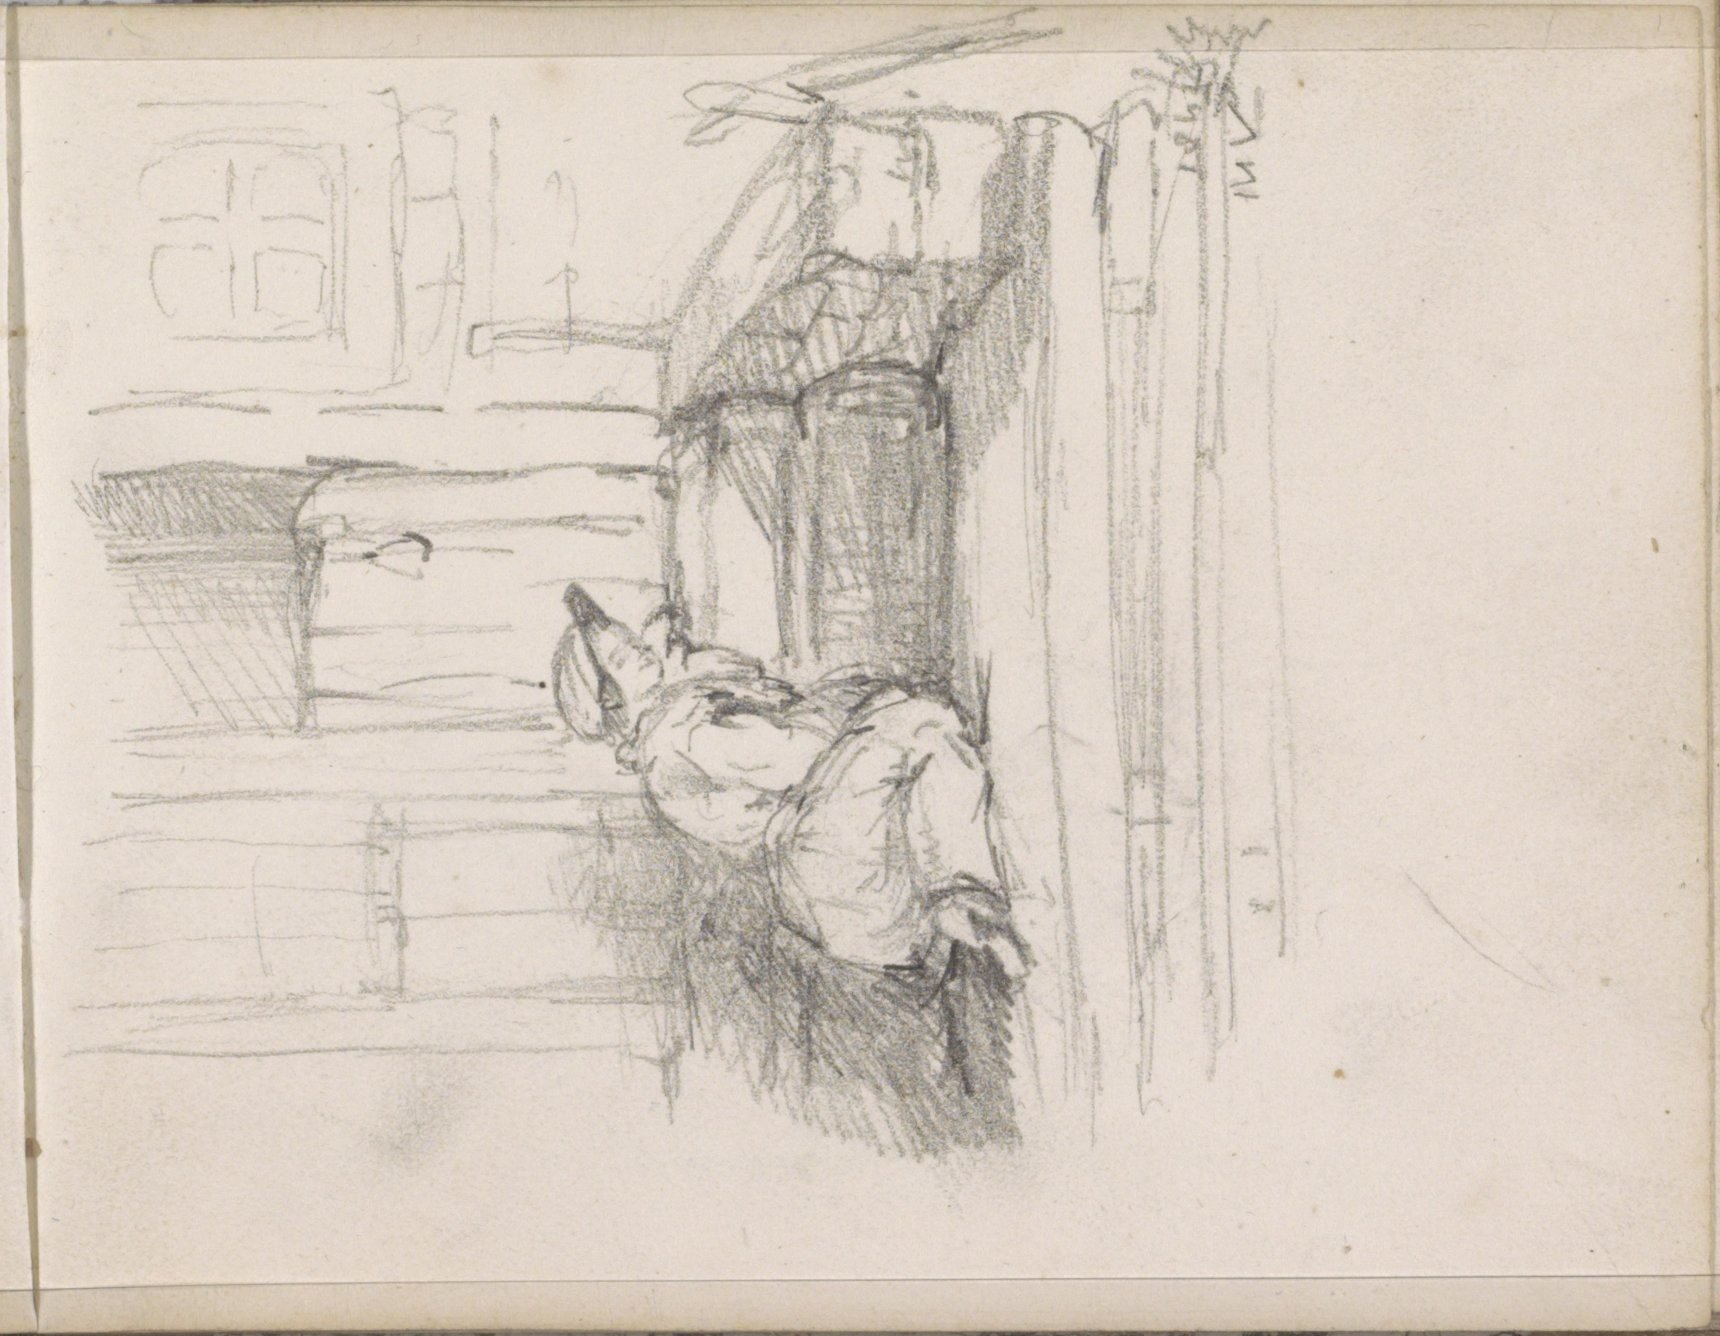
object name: sketchbook leaf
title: Interieur met een kind op een sofa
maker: maria vos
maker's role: draughtsman, painter, print maker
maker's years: 1824-1906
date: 1842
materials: paper, pencil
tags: child, interior of the house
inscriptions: monogram and date: ‘1842/ MV’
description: Blad 5 recto uit een schetsboek met 21 bladen.